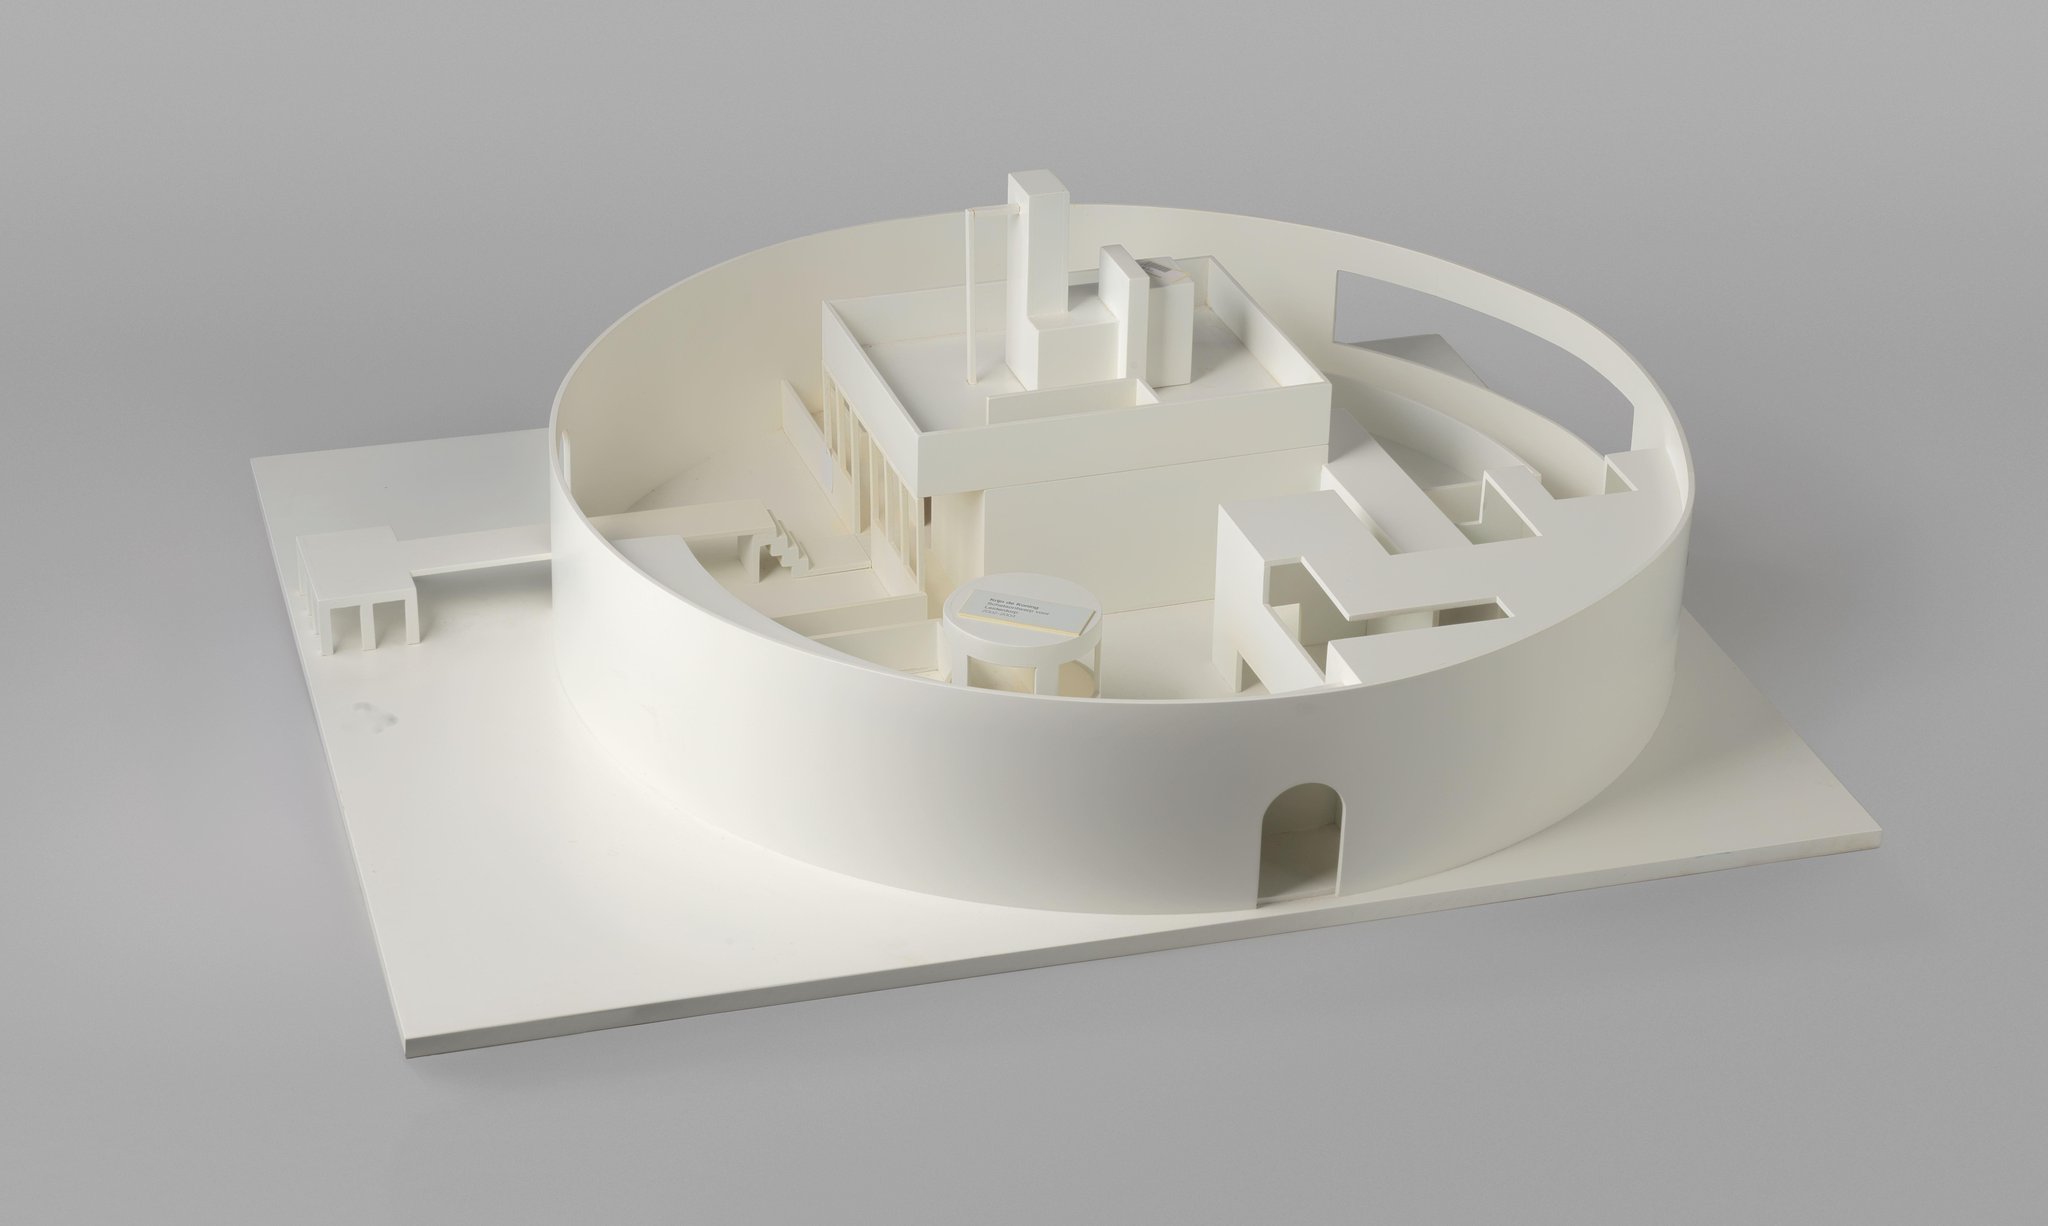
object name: model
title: Model voor een bouwwerk op het bouwterrein bij Leiderdorp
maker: krijn de koning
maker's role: sculptor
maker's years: 1963-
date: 2002-2003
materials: wood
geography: netherlands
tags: leiderdorp, aanleg traject hsl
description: Model voor bouwwerk op een bouwterrein geïnspireerd op de bouwketen in gebruik bij de aanleg van de Hoge Snelheidslijn van Amsterdam naar Parijs. Gemaakt in opdracht van Atelier HSL.